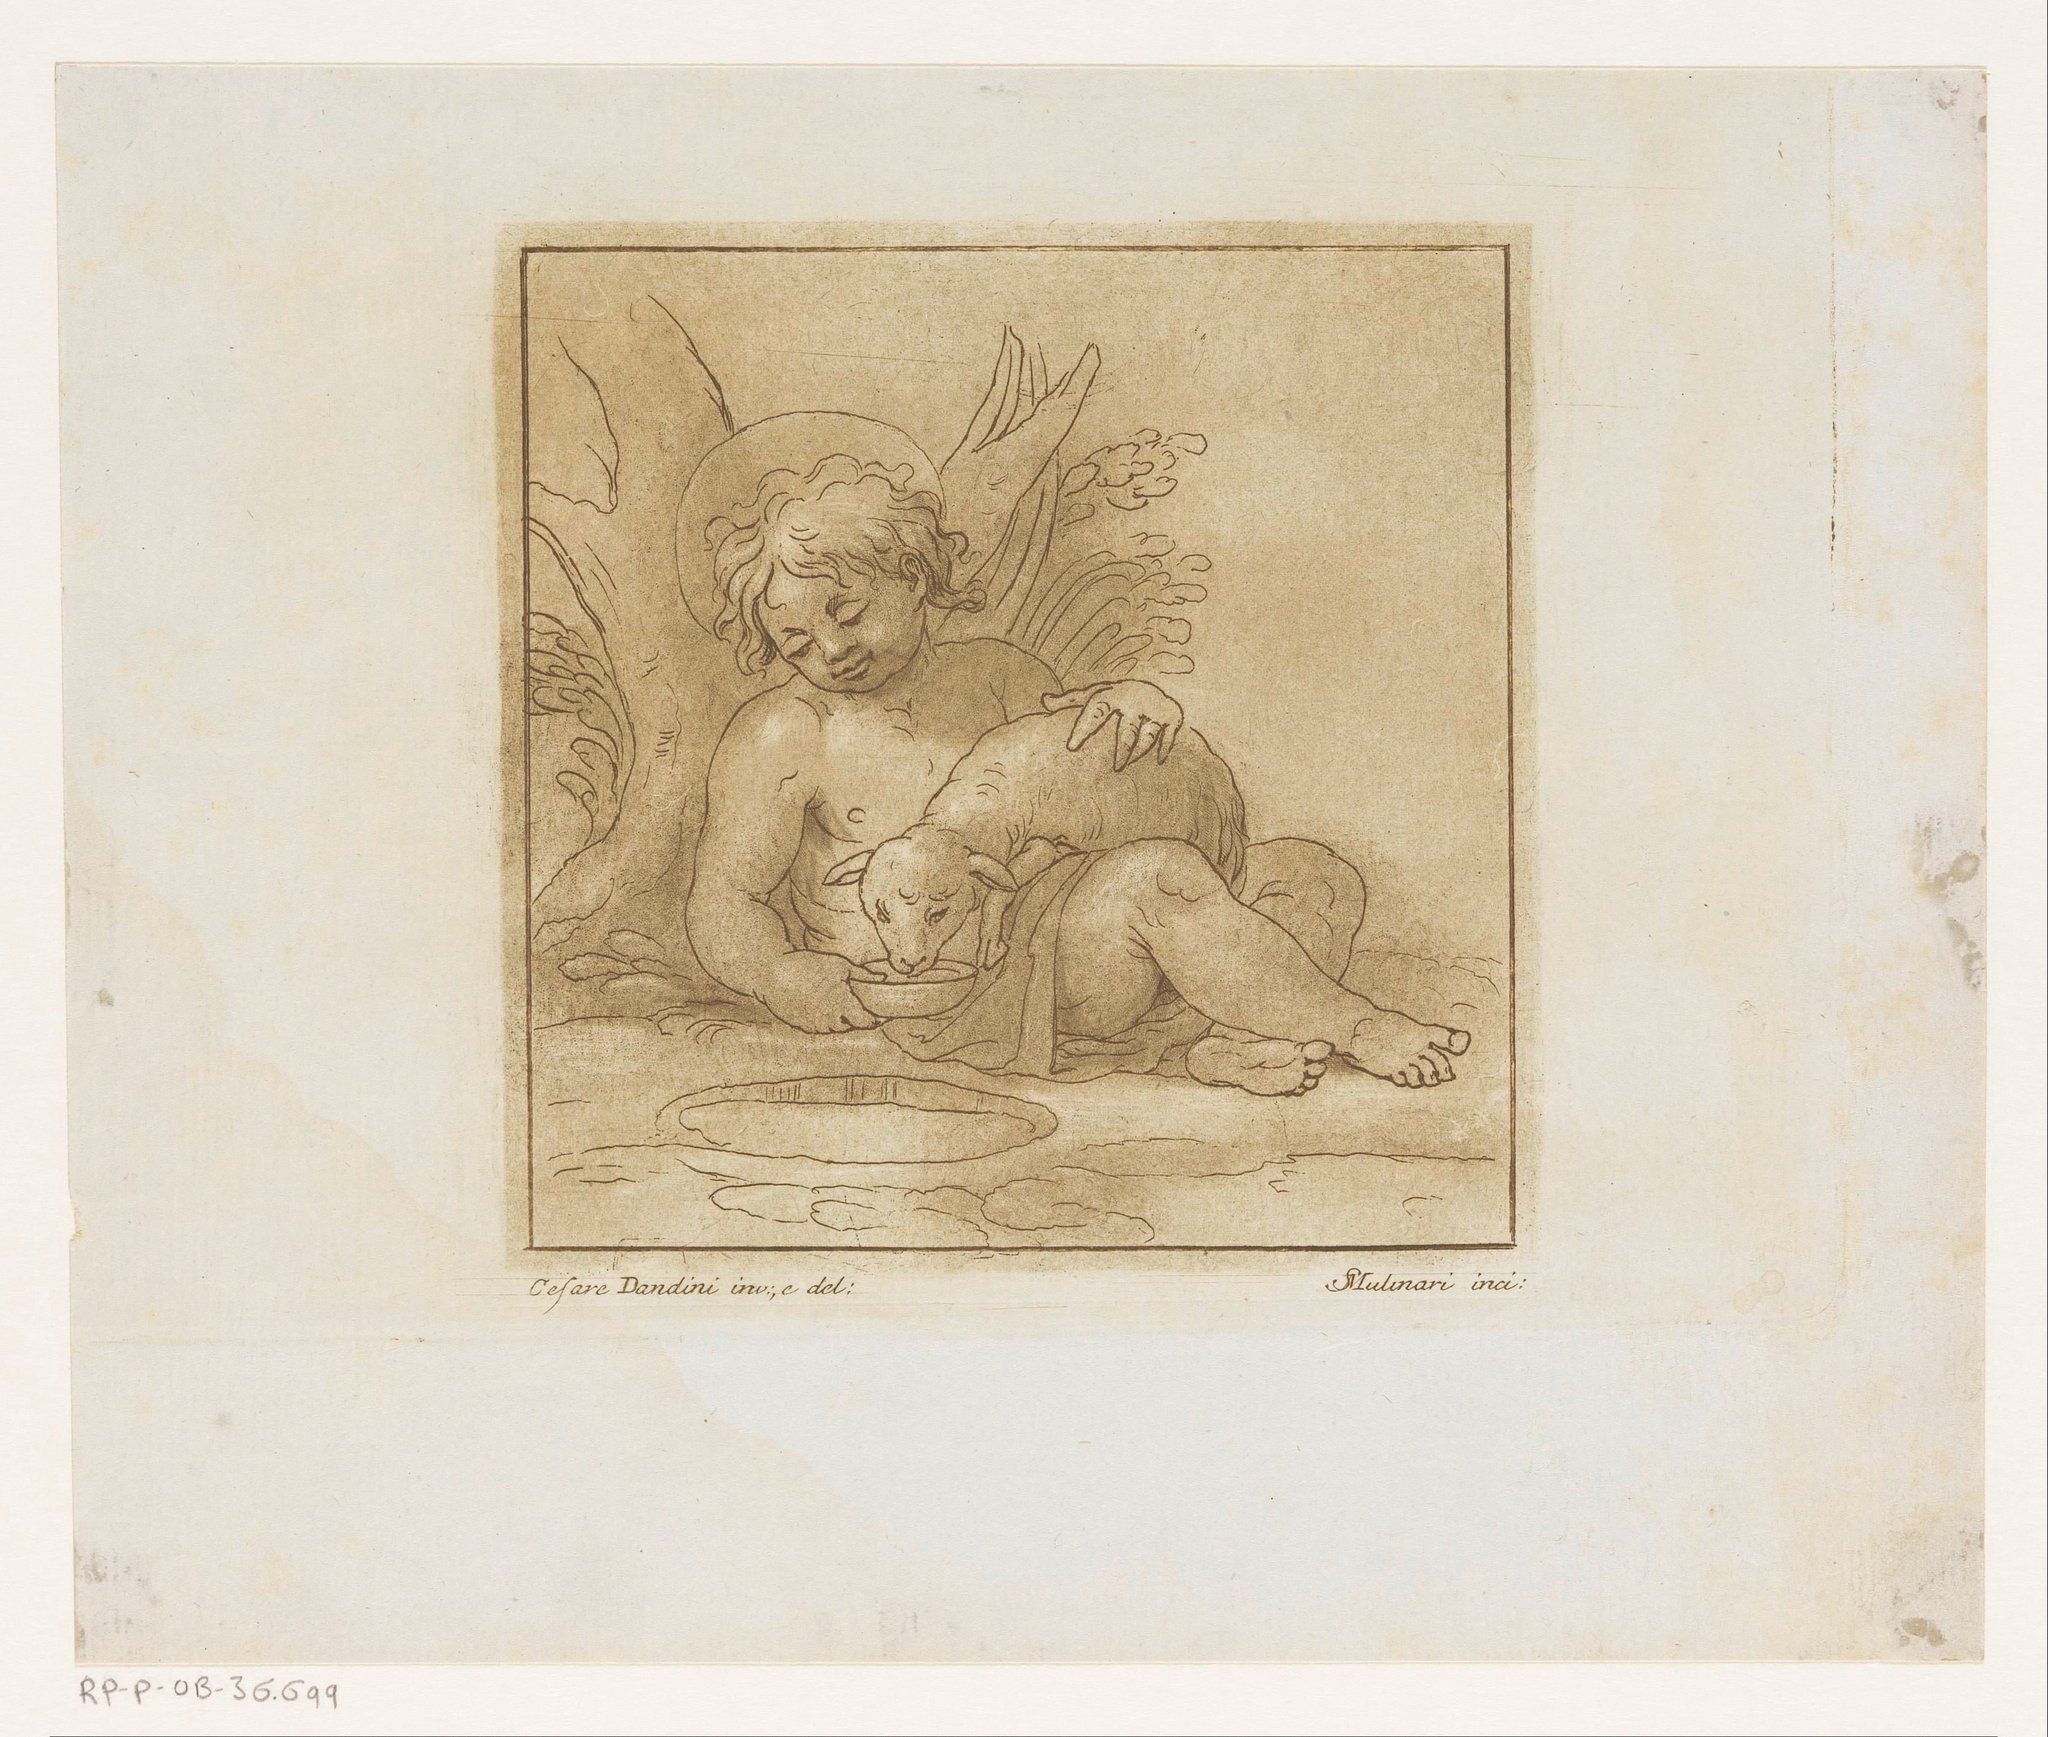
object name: print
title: Johannes de Doper in de wildernis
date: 1751-1790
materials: paper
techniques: aquatint, etching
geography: italy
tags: john the baptist in the wilderness, usually accompanied by a lamb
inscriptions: collector's mark: Lugt 2228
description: De jonge Johannes de Doper zit rustend bij een boom. Op zijn schoot het lam, drinkend uit een kom.